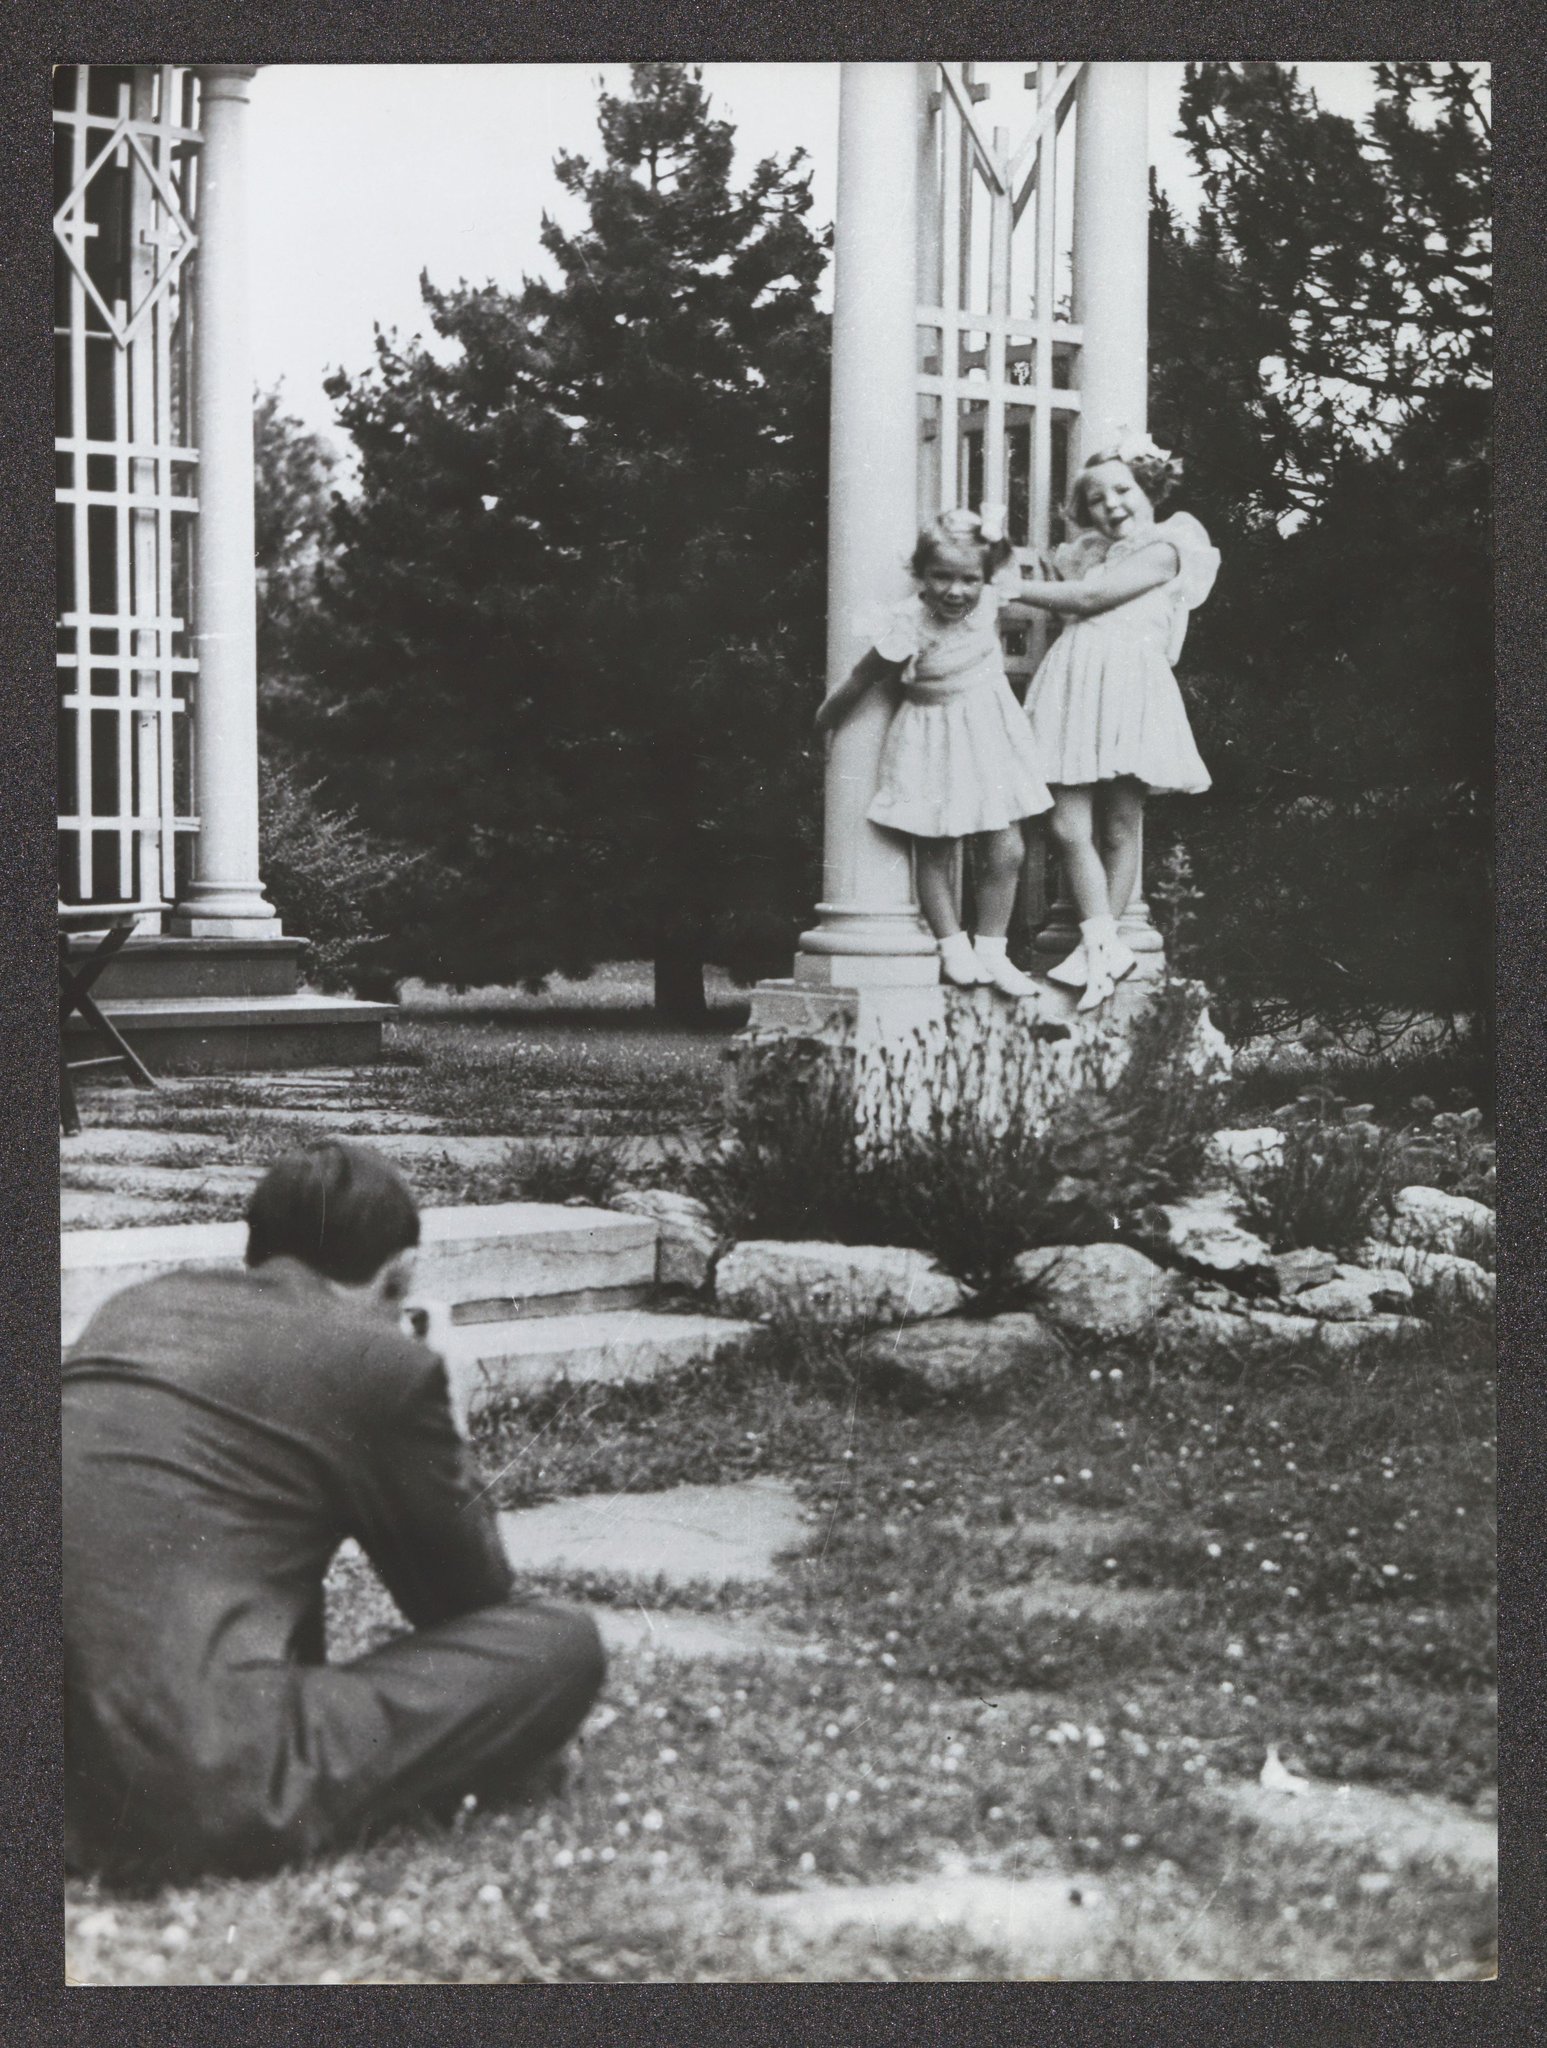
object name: photograph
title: Prins Bernhard fotografeert zijn dochters Beatrix en Irene in Ottawa, Canada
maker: yousuf karsh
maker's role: fotograaf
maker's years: 1908-2002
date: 1943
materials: paper, photographic support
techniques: gelatin silver print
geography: netherlands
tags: utrecht, bernhard (prins der nederlanden), beatrix (koningin der nederlanden)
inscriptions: signature: ‘COPYRIGHT / "ANEFO" / KERKSTRAAT 310 / AMSTERDAM-C. / TEL. 30744 33902 / No. [in potlood ingevuld: PRF131]’